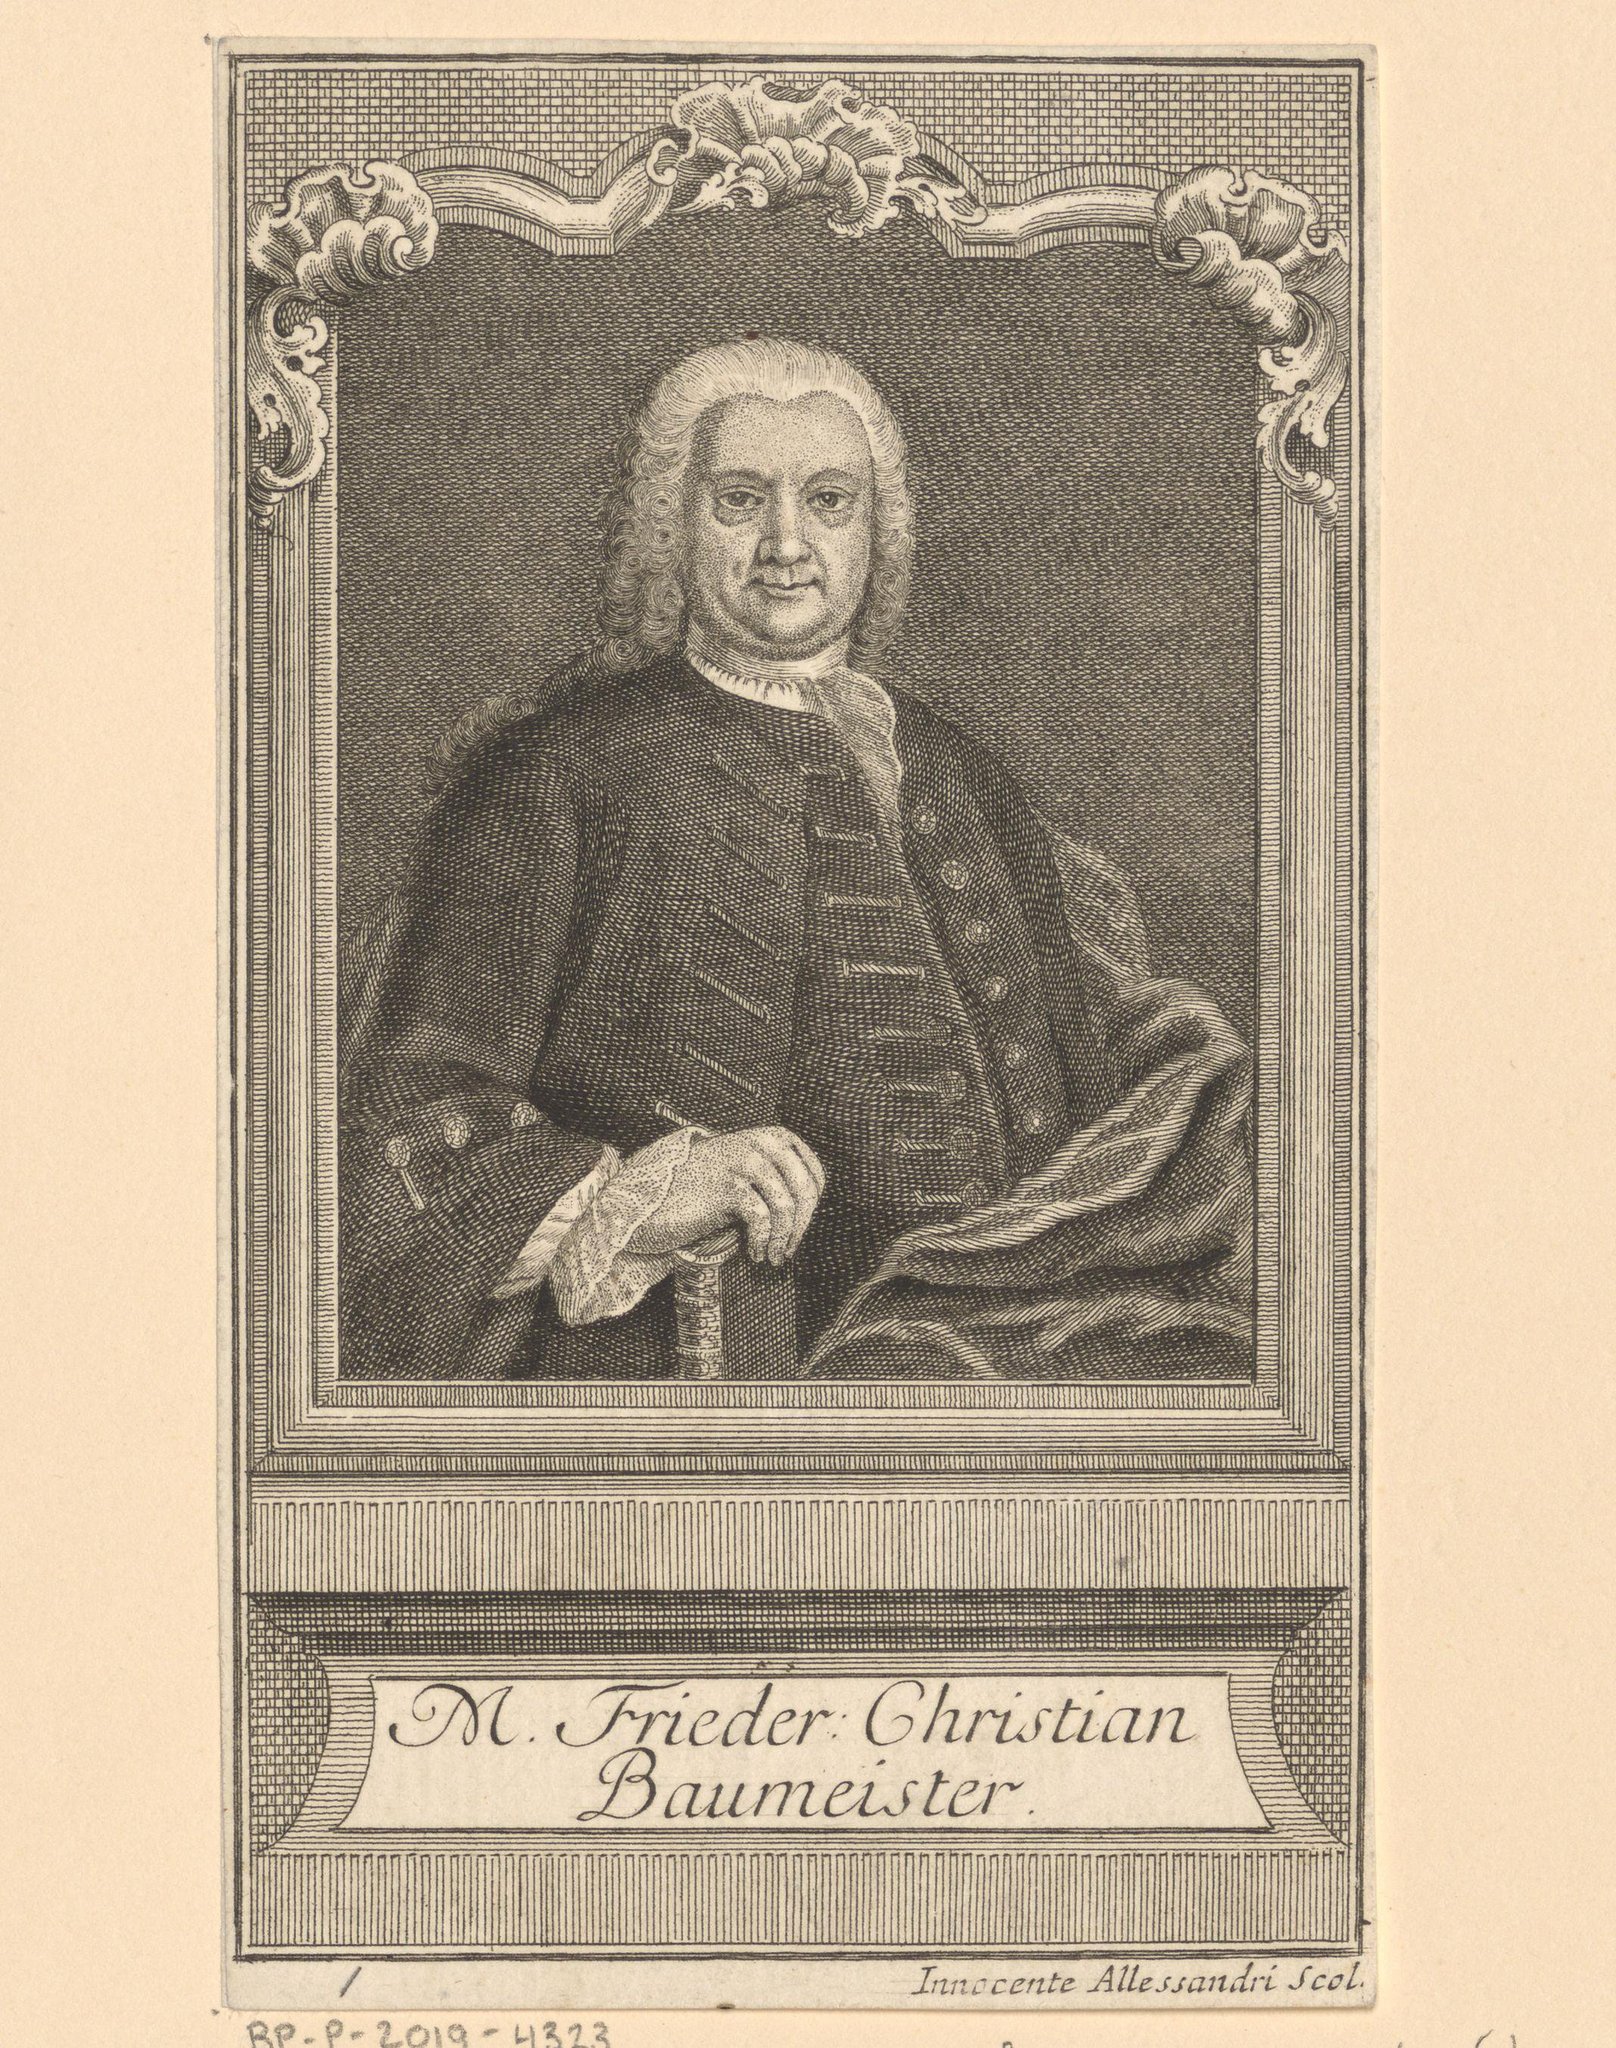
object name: print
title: Portret van Friedrich Christian Baumeister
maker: innocente alessandri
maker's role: print maker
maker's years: 1740-1803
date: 1750-1803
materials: paper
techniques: engraving, etching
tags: historical persons